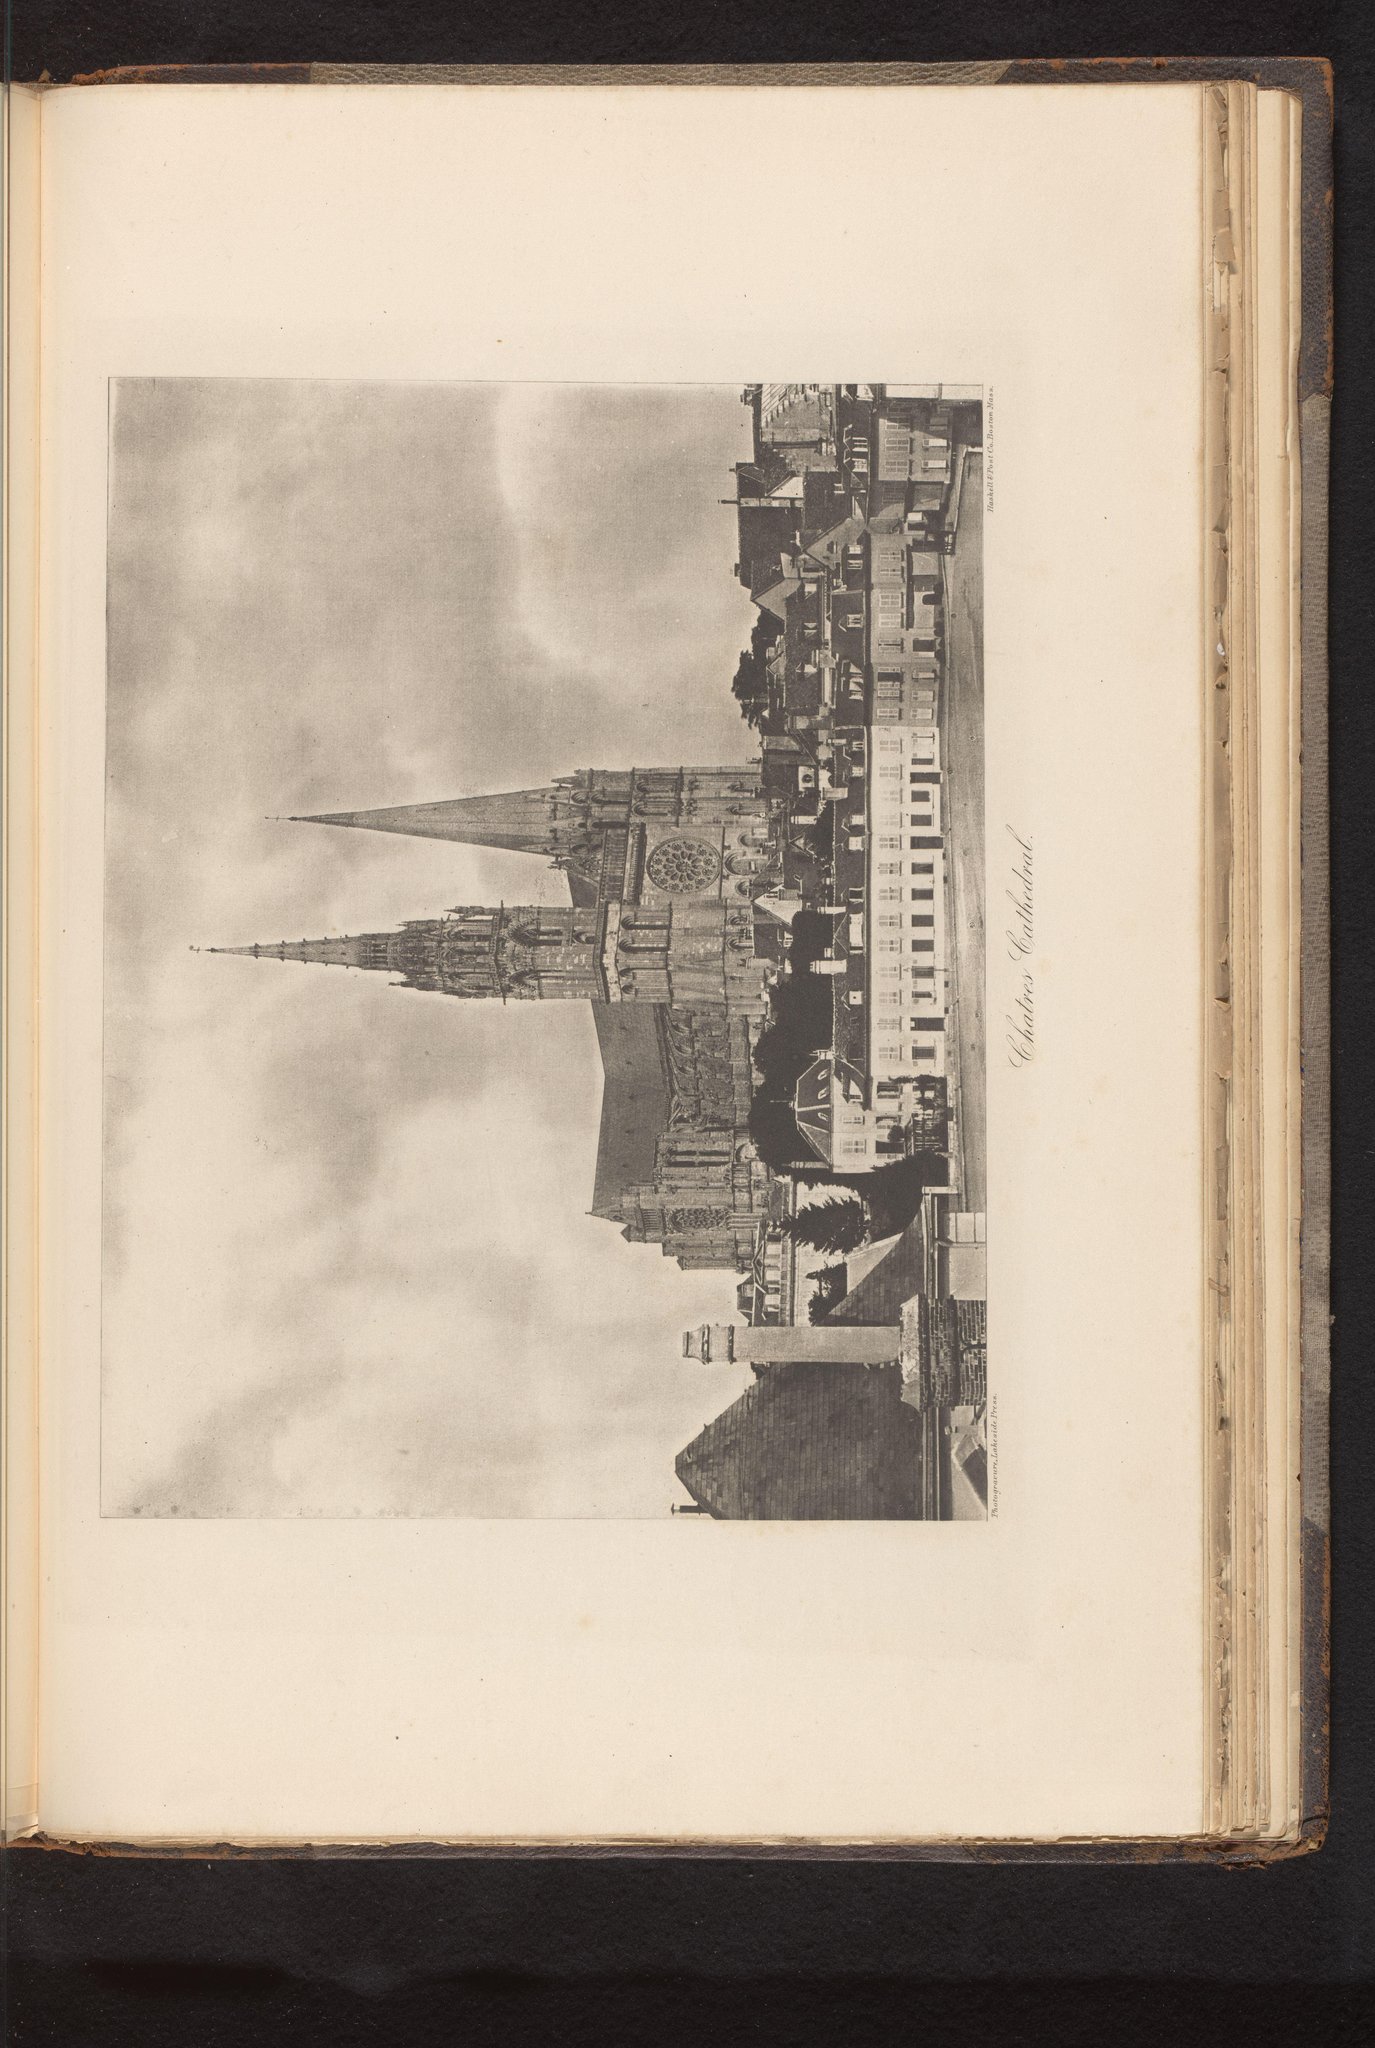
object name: page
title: Chatres Cathedral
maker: Anonymous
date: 1881-1886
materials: paper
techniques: photograph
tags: city-view in general; 'veduta', church (exterior)